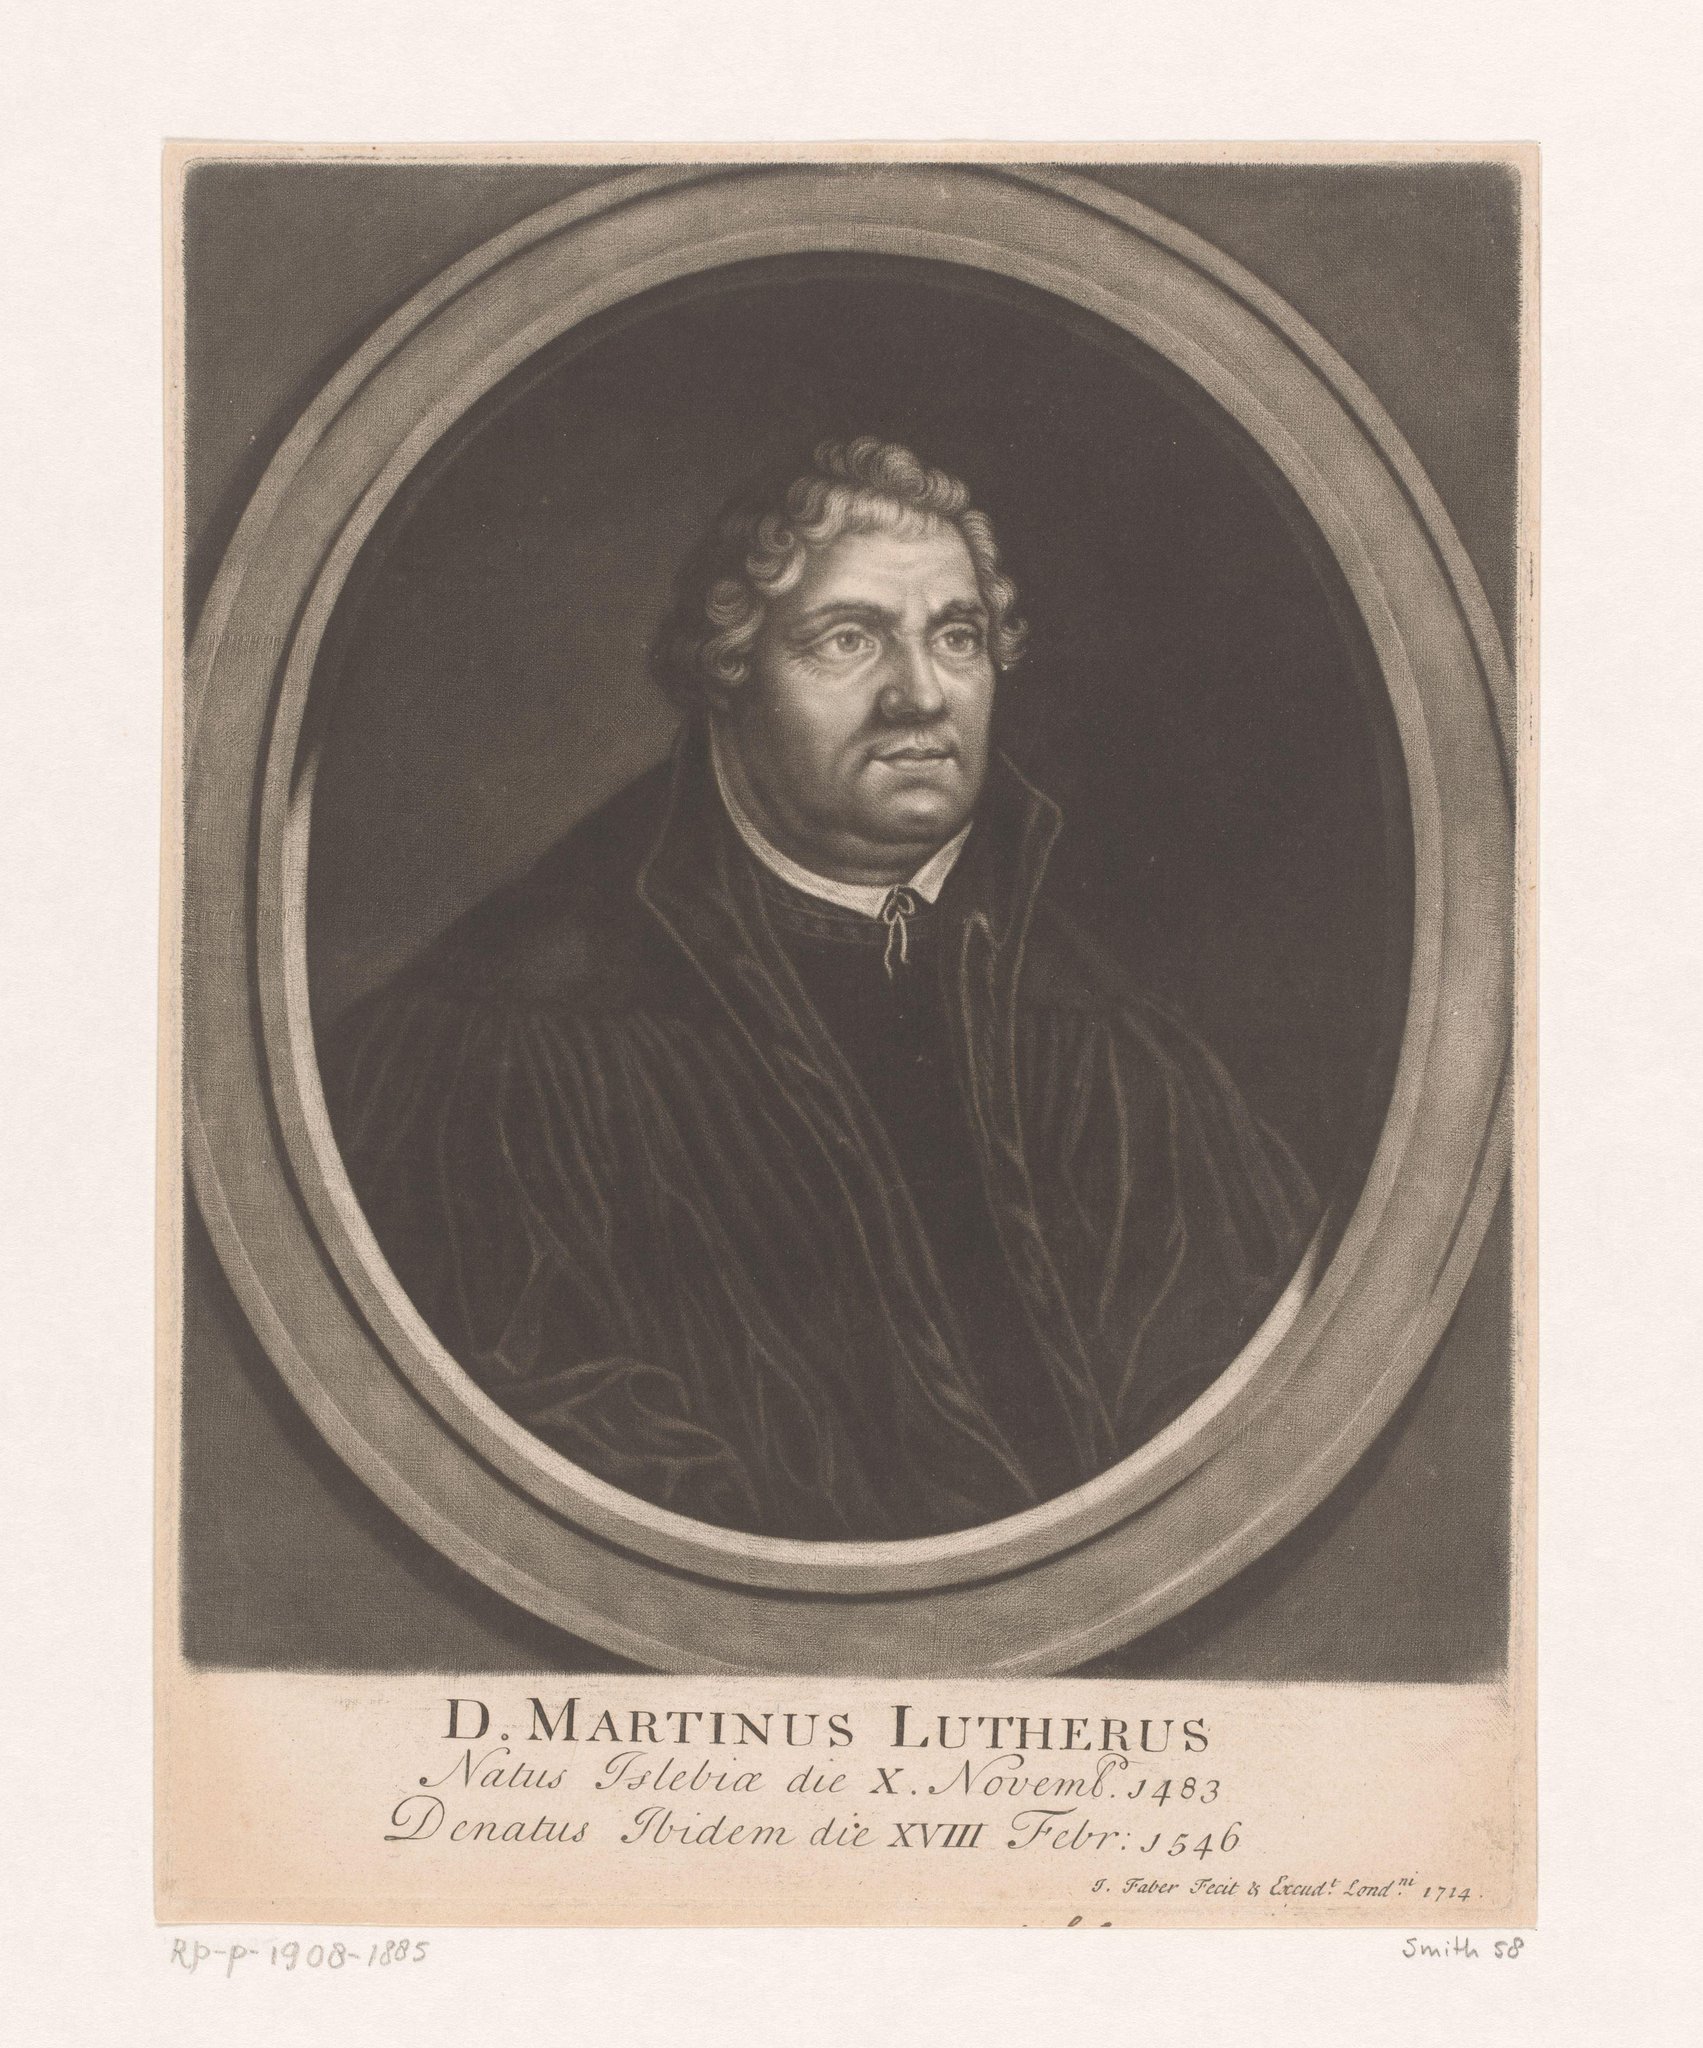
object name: print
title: Portret van Martin Luther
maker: john faber (i)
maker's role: draughtsman, print maker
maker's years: 1650-1721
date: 1714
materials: paper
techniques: mezzotint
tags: priest, martin luther, reformation (roman catholic church vs. protestantism), historical persons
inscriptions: collector's mark: Lugt 2228